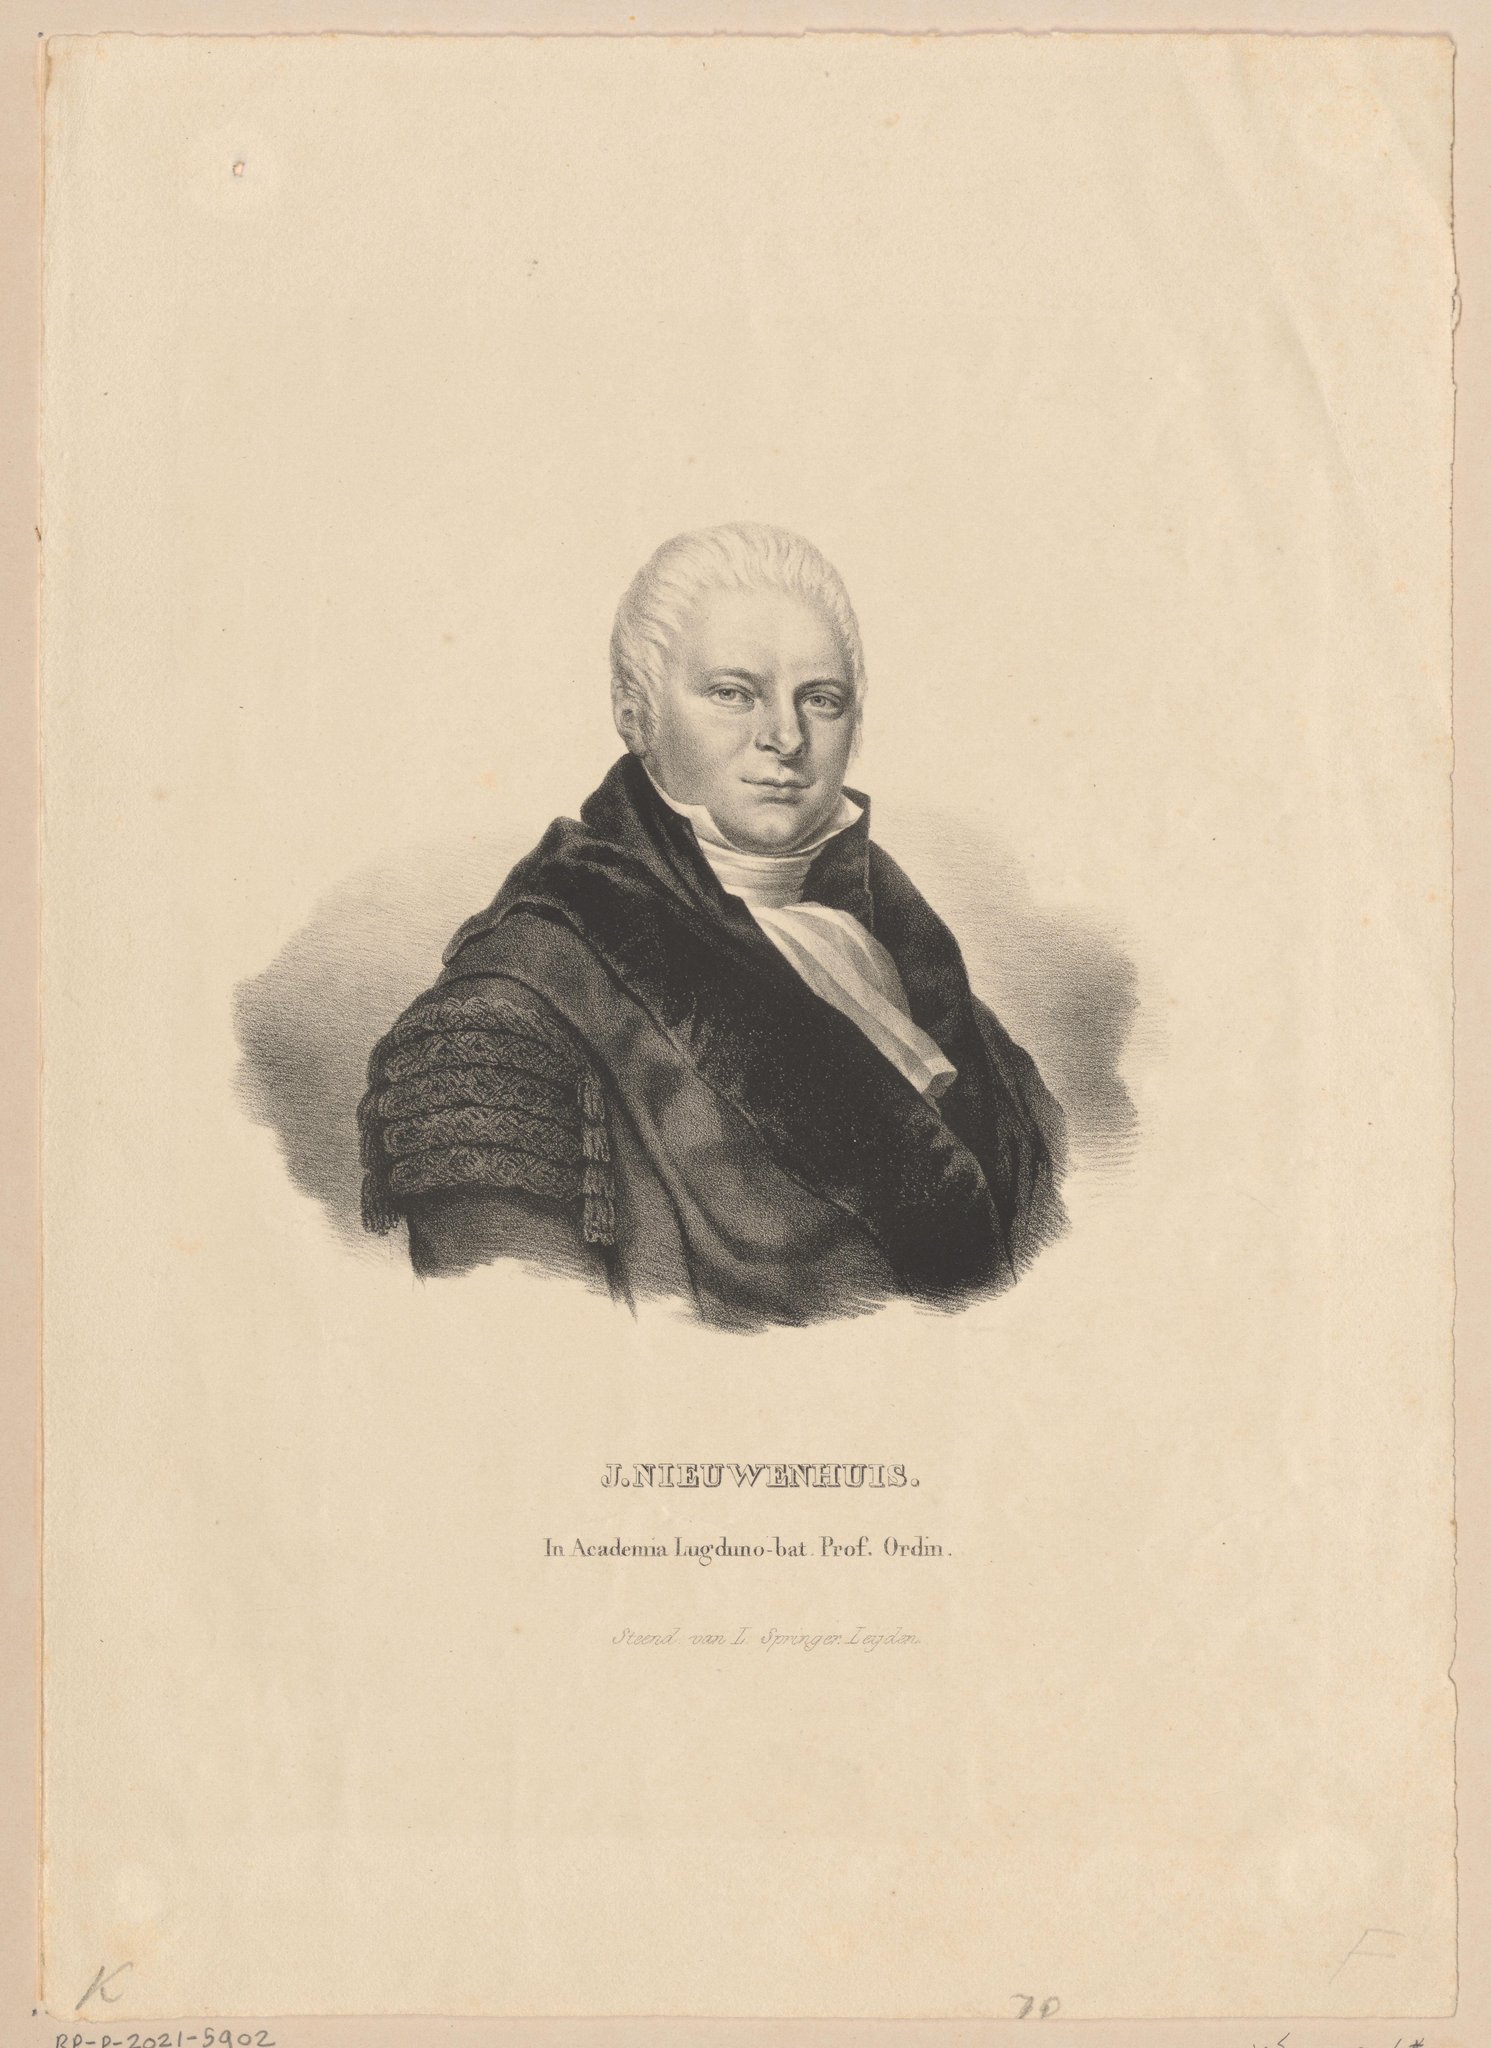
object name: print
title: Portret van Jacob Nieuwenhuis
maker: leendert springer (i)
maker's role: draughtsman, painter, print maker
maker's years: 1789-1871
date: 1828-1858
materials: paper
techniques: lithograph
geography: leiden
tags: vleuten, historical persons, professor